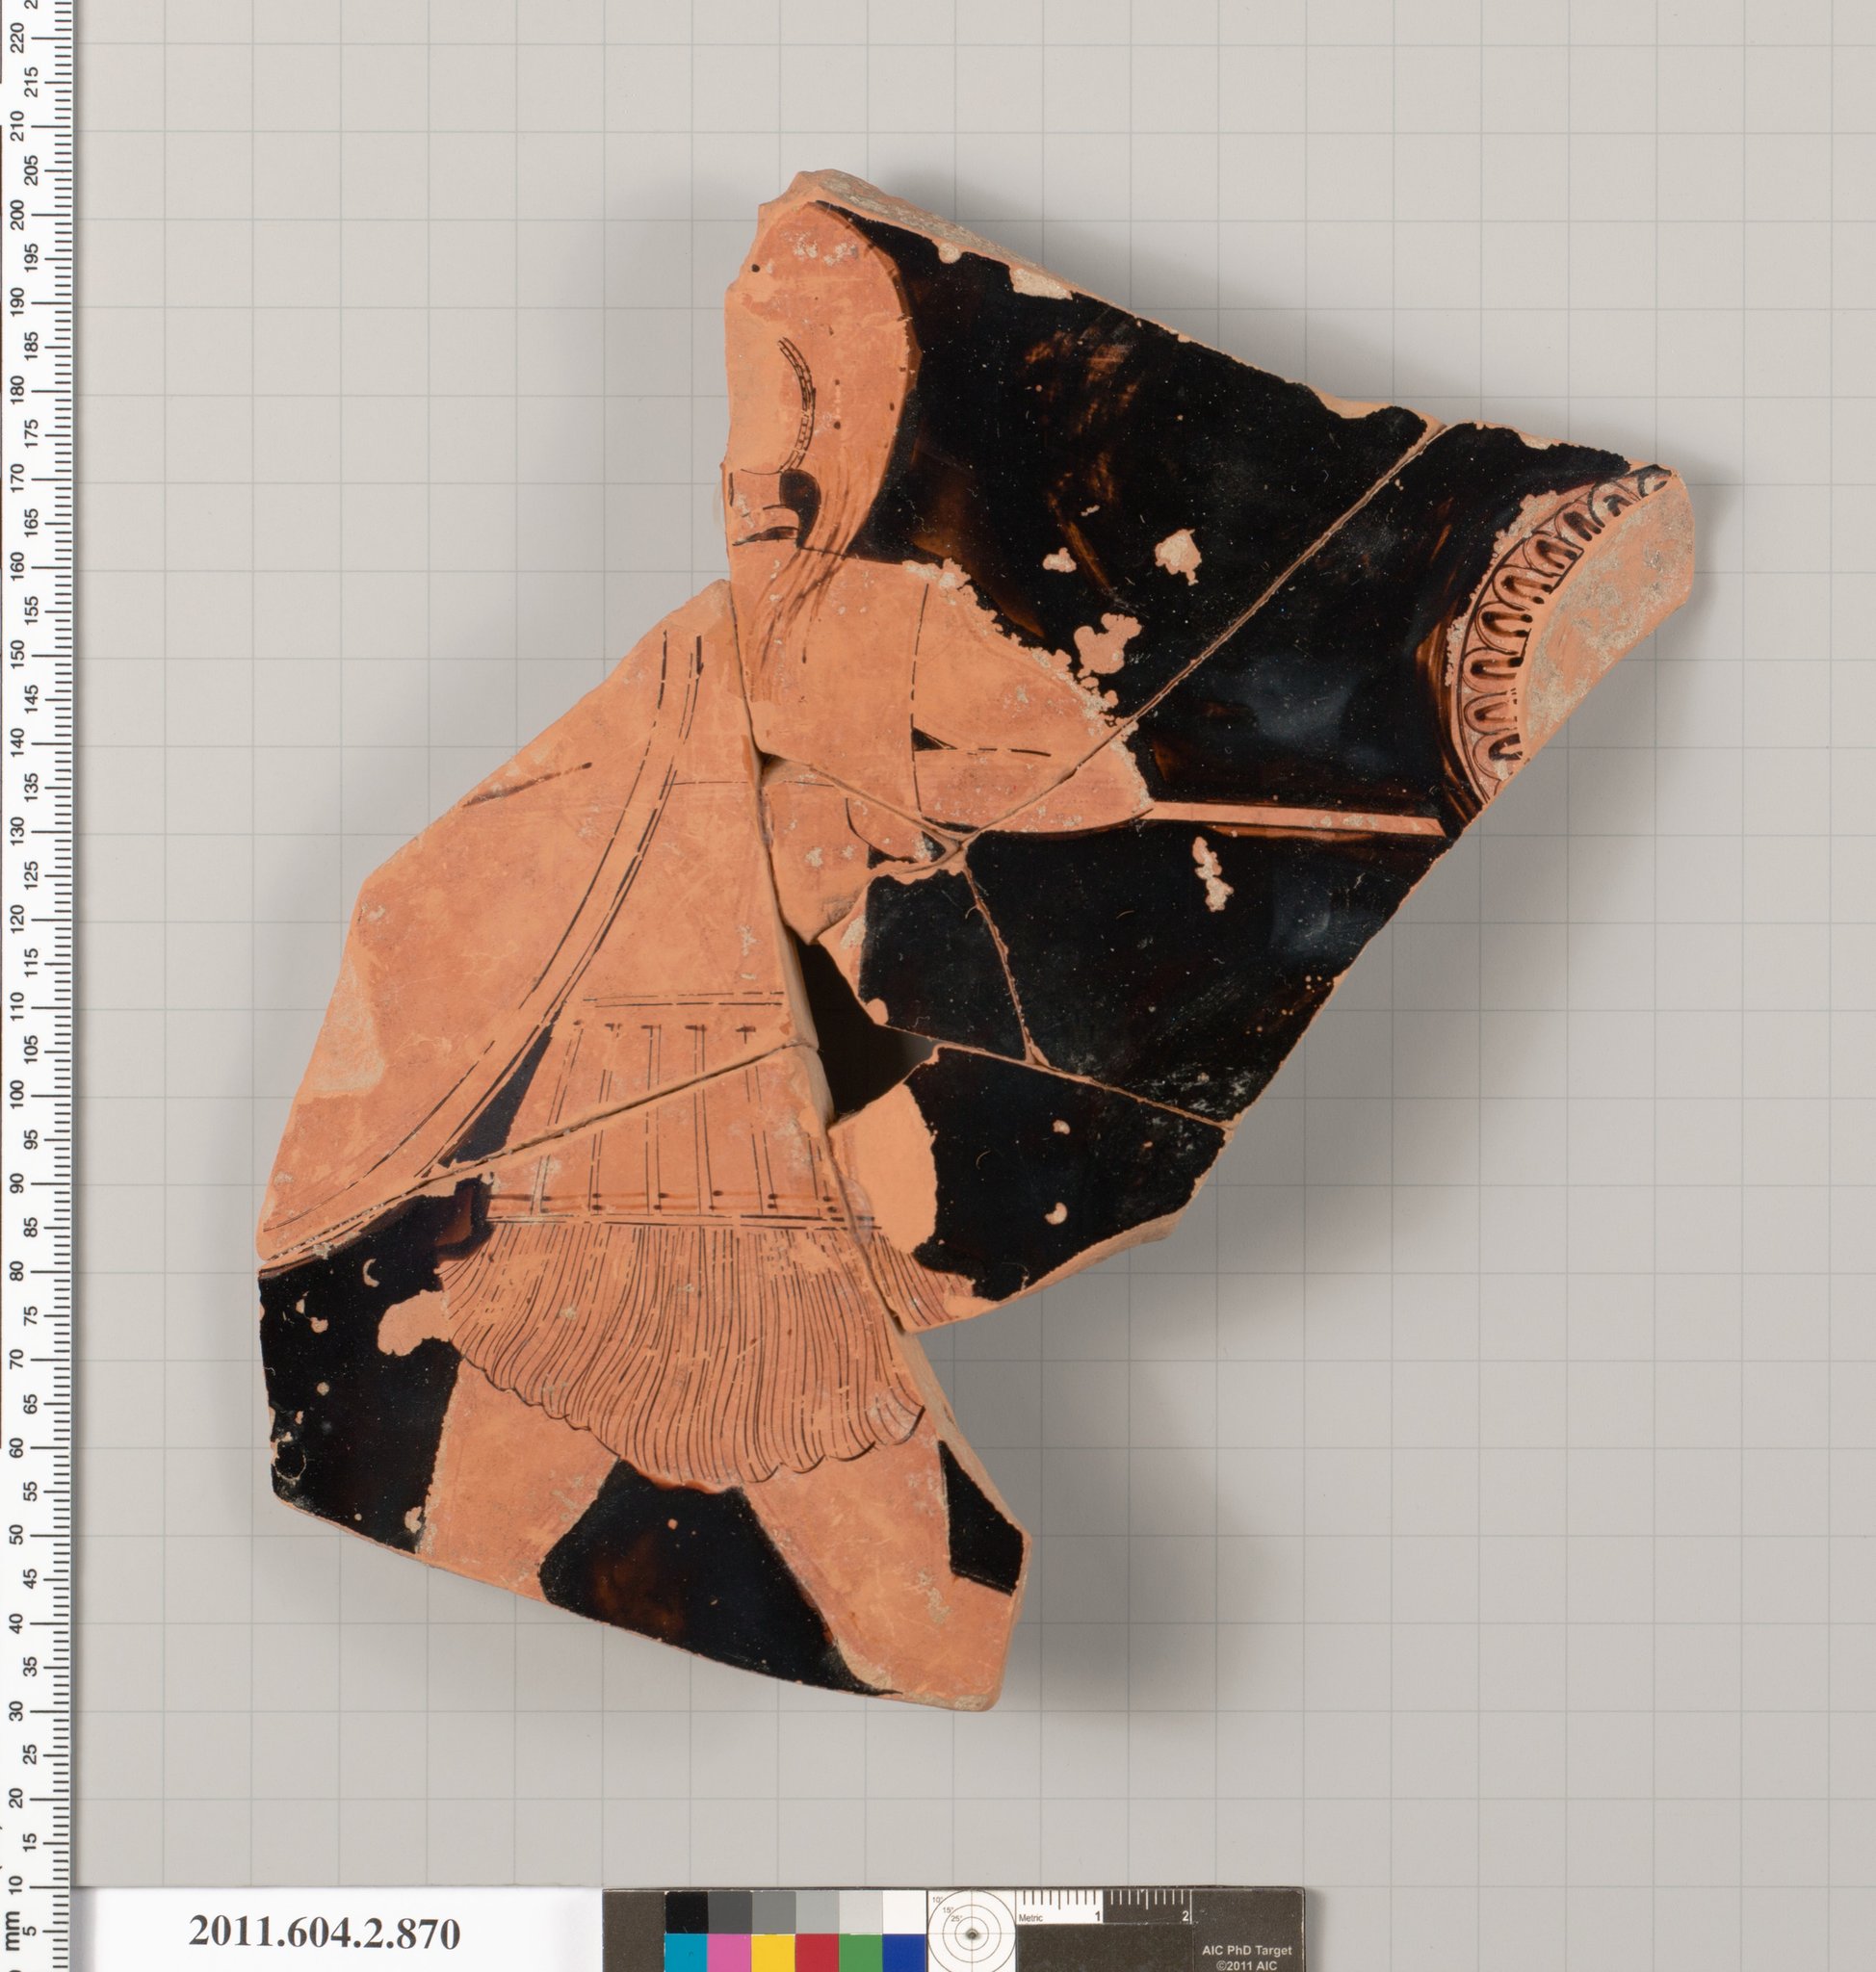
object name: bell krater fragment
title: Terracotta fragment of a bell-krater (bowl for mixing wine and water)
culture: greek, attic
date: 440 BCE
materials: terracotta